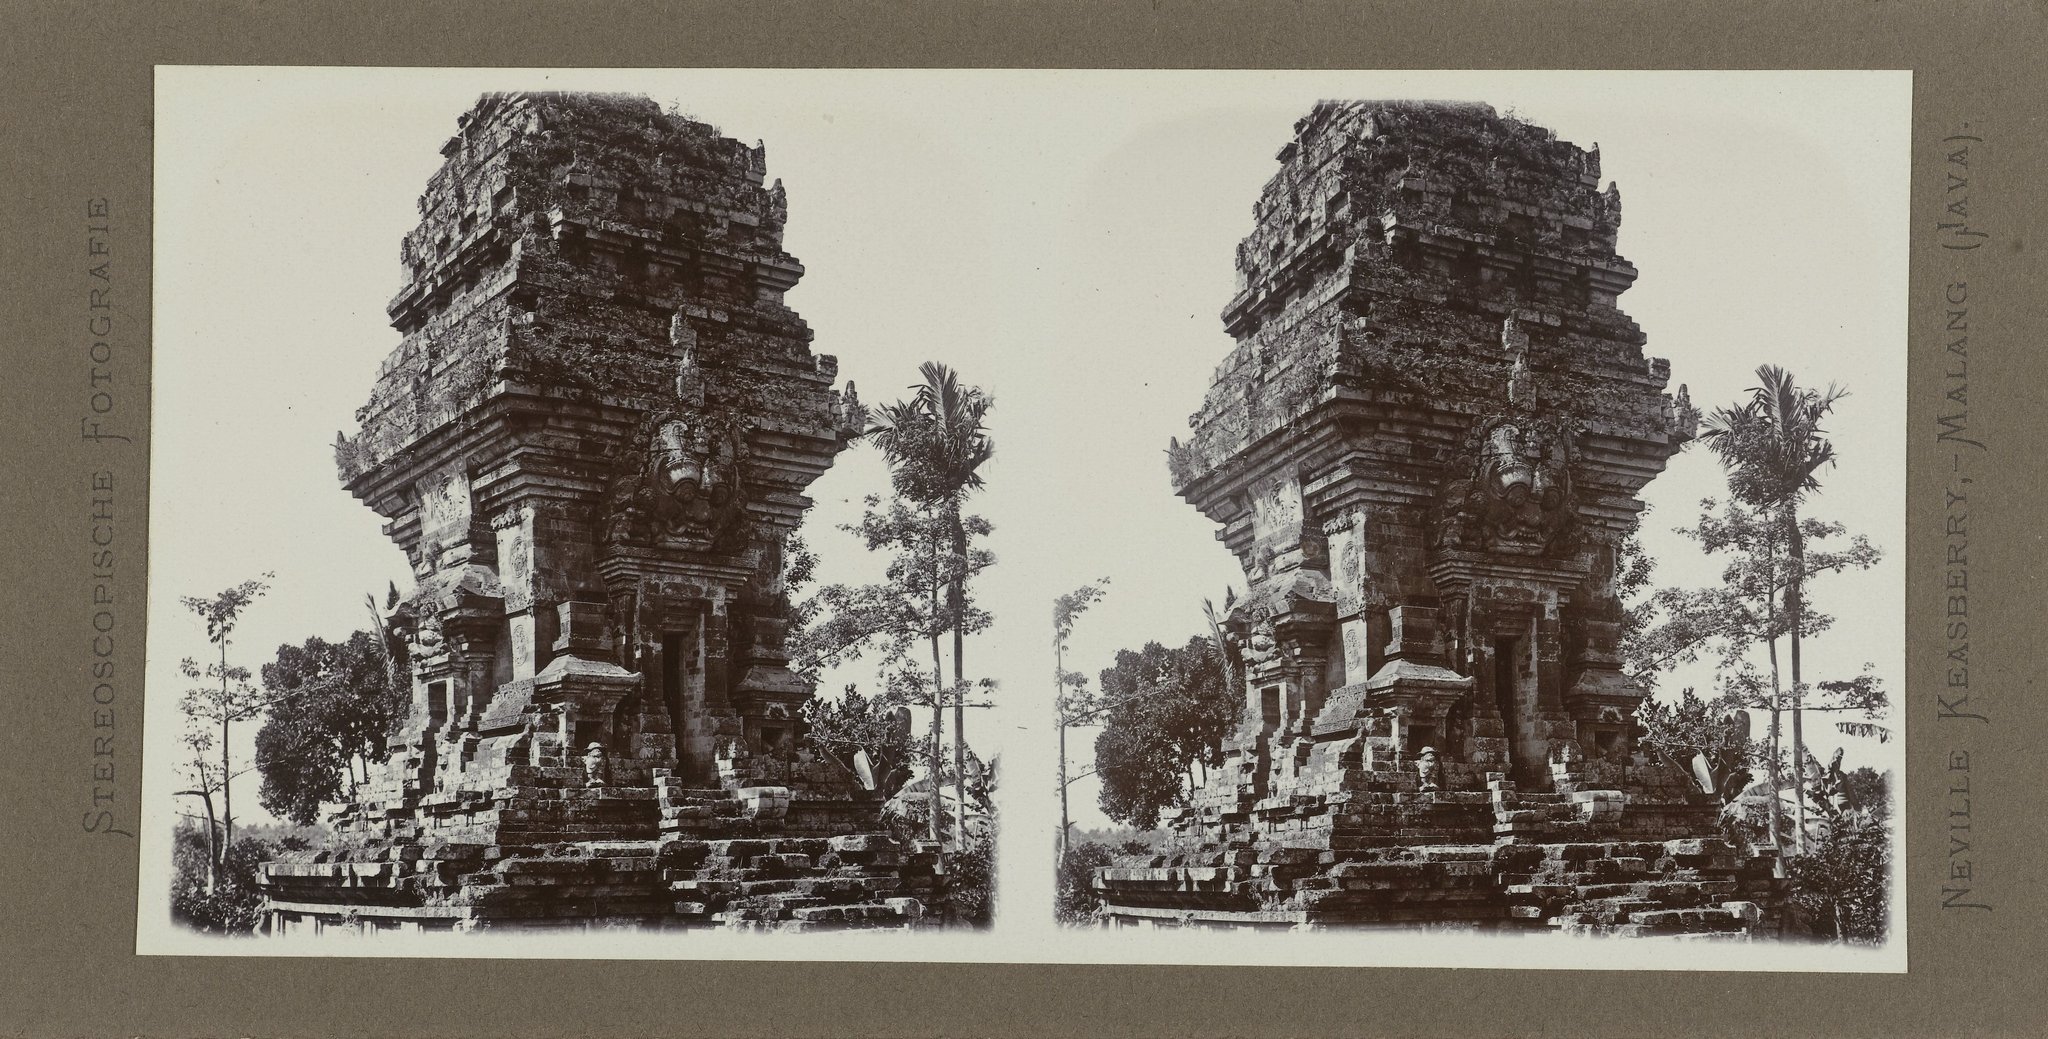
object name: photograph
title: S 7 No 73. De Tjandie Kidal bij Toempang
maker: neville keasberry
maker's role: fotograaf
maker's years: 1866-1944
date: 1900-1935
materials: cardboard, paper, photographic support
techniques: albumen print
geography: malang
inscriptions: inscription: ‘Stereoscopische Fotografie’, signature: ‘Neville Keasberry, Malang (Java)’